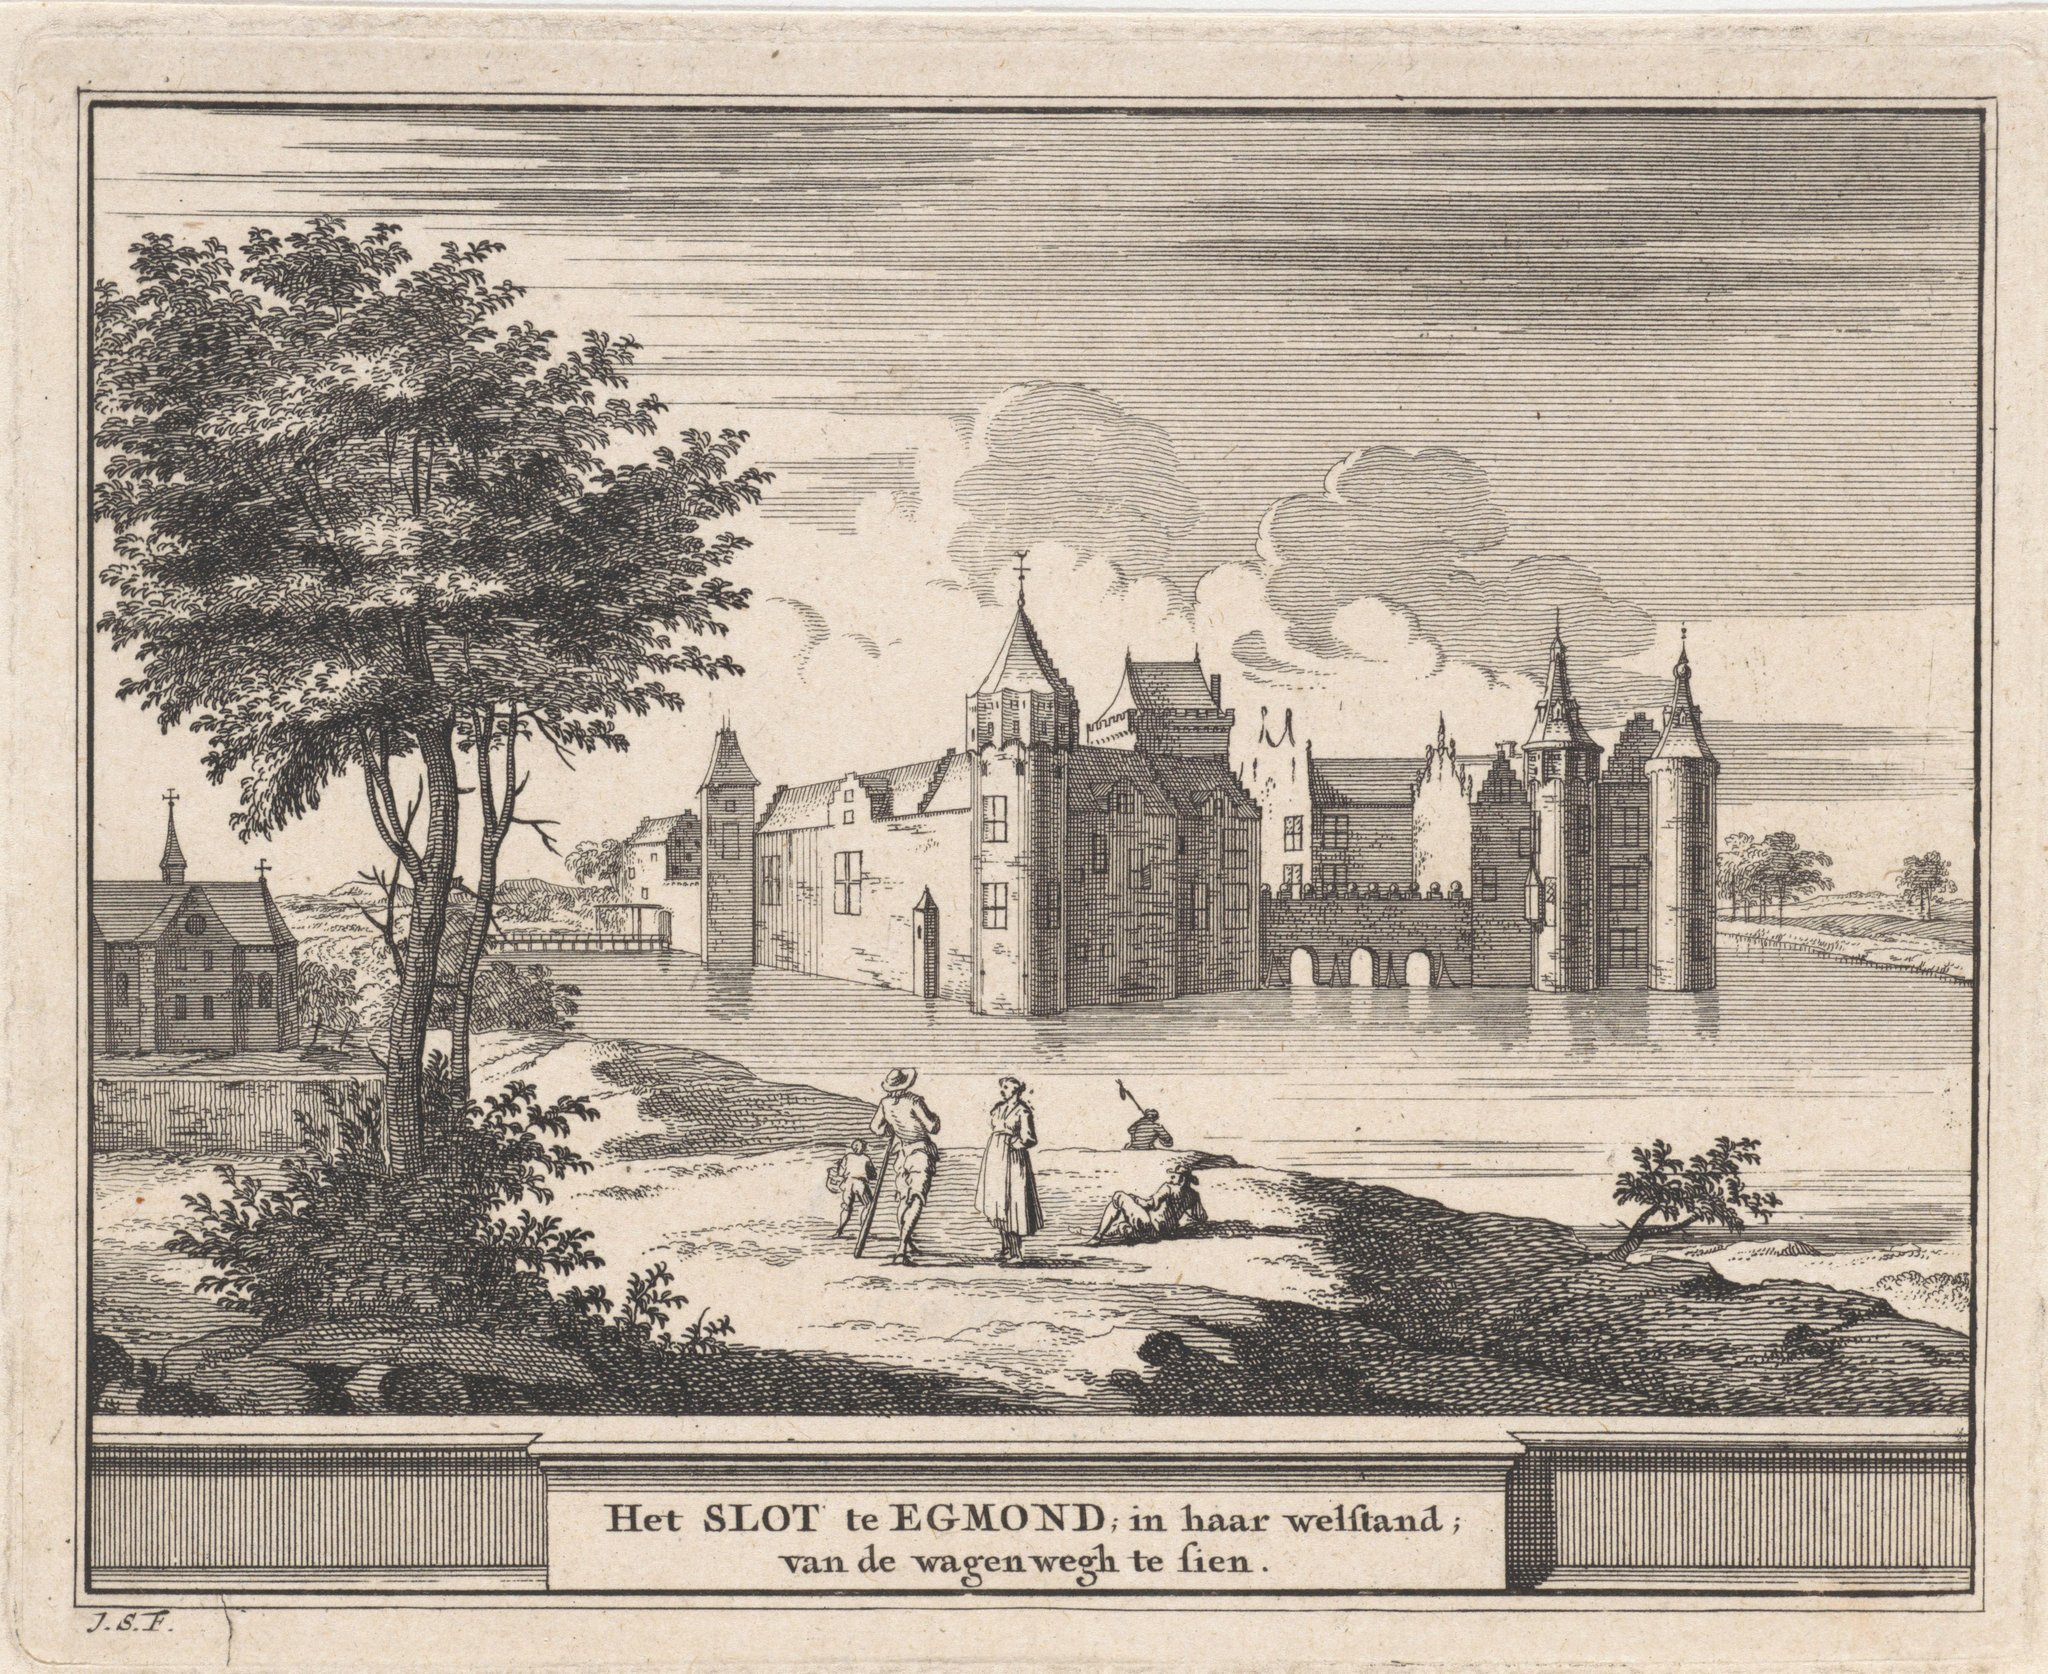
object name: print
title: Het Slot te Egmond; in haar welstand; van de wagenwegh te sien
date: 1711-1774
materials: paper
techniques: etching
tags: castle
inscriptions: collector's mark: Lugt 2228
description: Prent als illustratie opgenomen in: Smids, Ludolph. Schatkamer der Nederlandsse[!] oudheden; of Woordenboek, behelsende Nederlands steden, Amsterdam: Pieter de Coup, 1711. Verscheen tevens in de heruitgave van voorgenoemd werk in 1737 en 1774. In 1721 verscheen er een uitgave met alleen de prenten: Nederlandsche oudheden, bestaande in zestig verbeeldingen (...) gelegen in Holland, 't Sticht van Utrecht en Gelderland enz. Amsterdam: Hendrik Bosch, 1721.